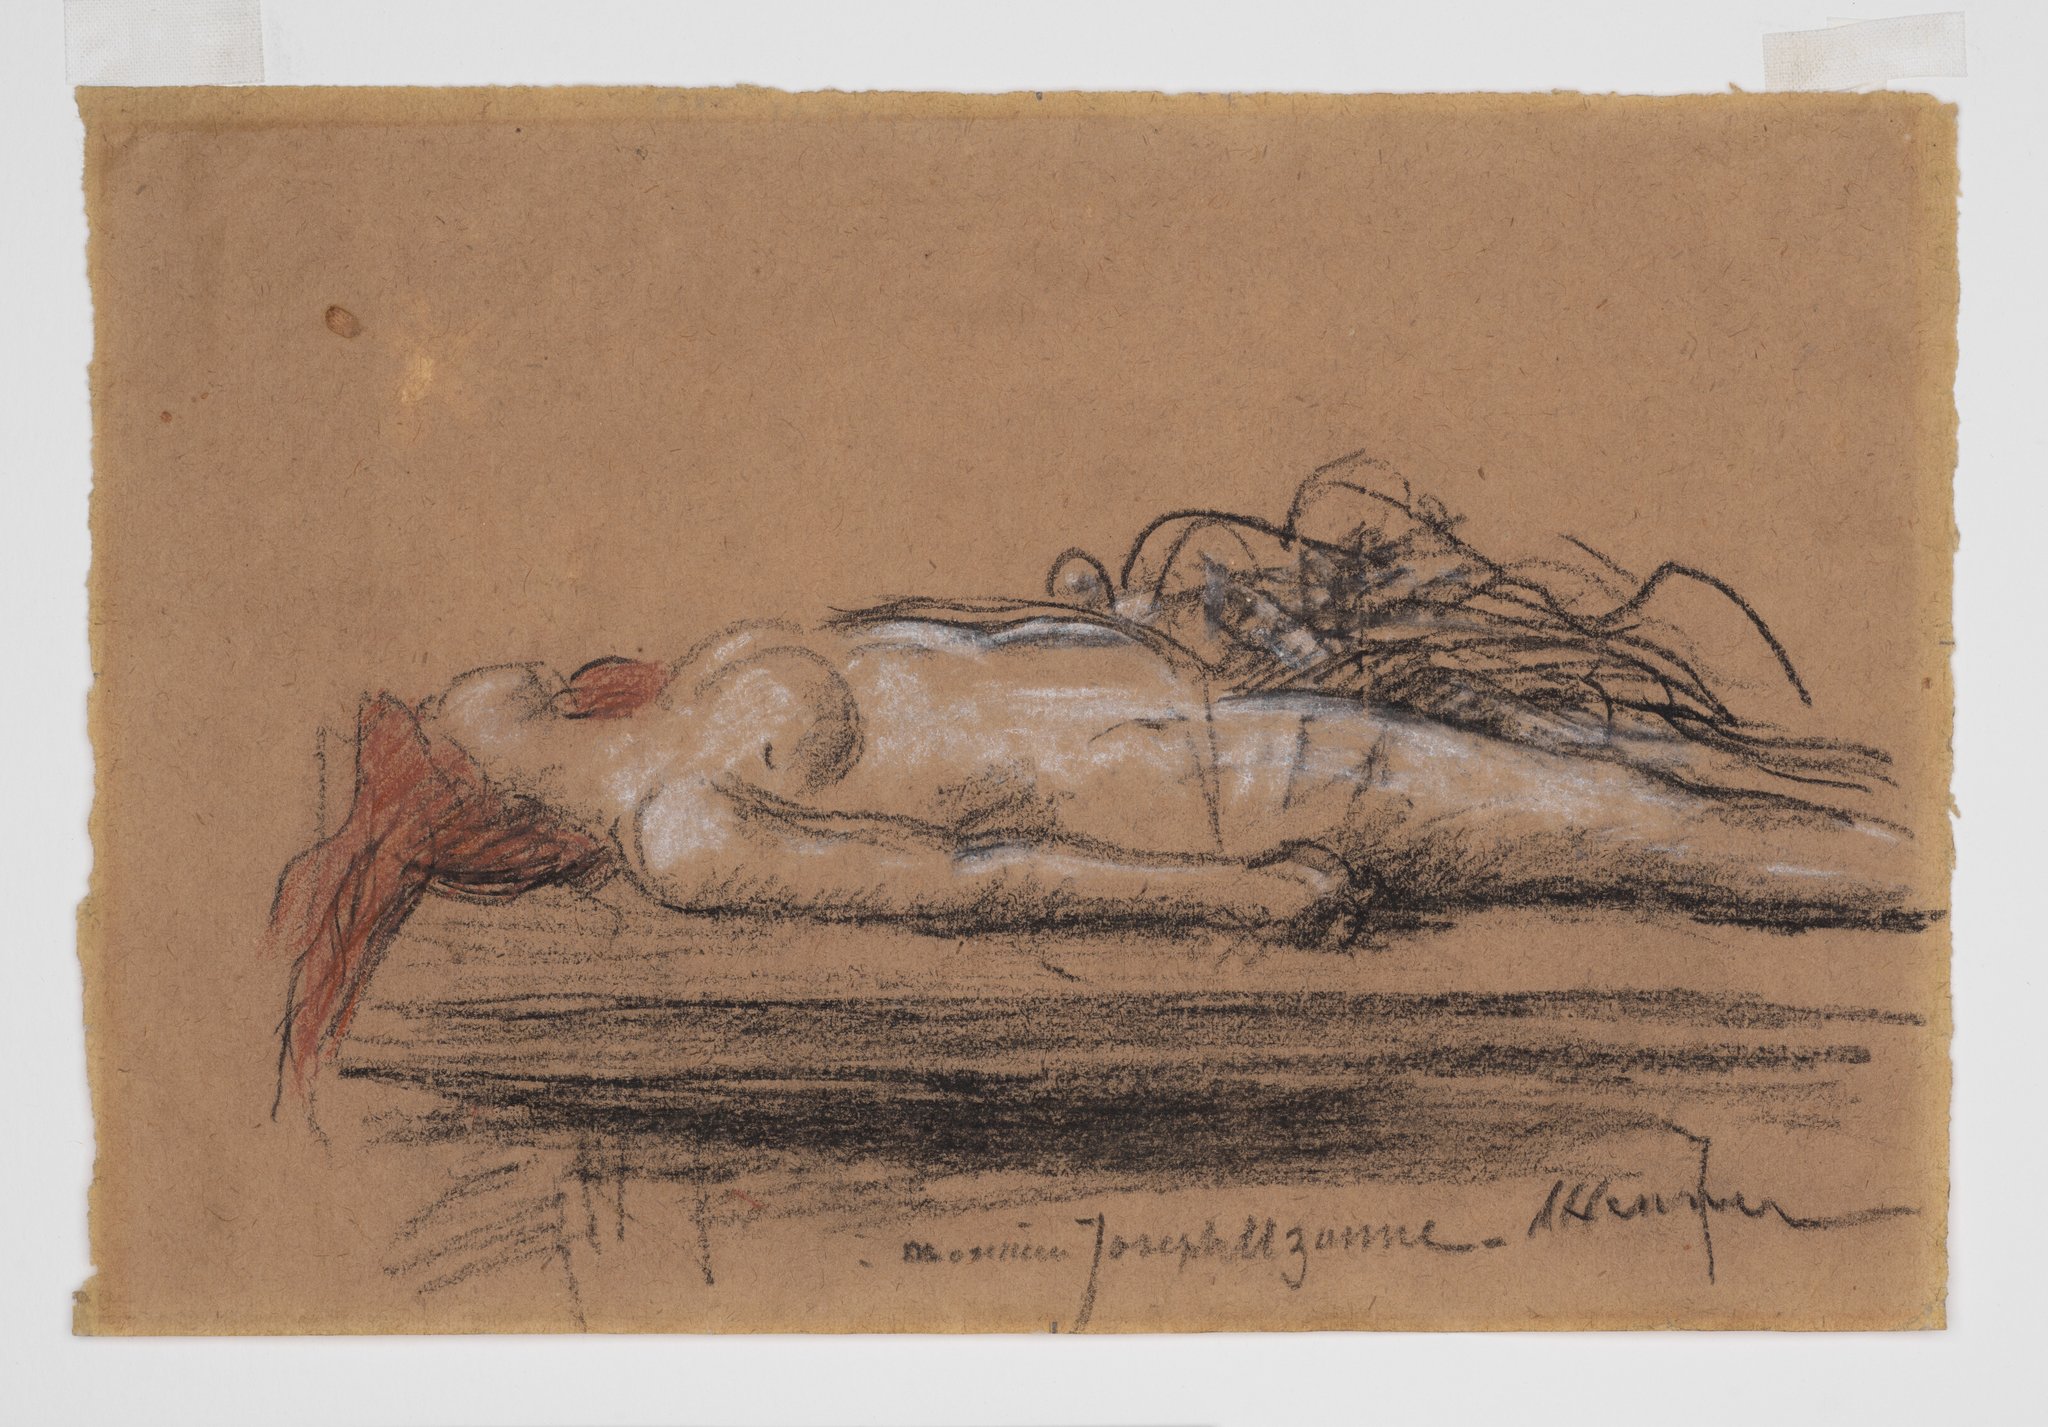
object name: drawing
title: Wife of the Levite from Ephraim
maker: jean-jacques henner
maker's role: artist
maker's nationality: french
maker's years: 1829-1905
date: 1894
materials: crayon